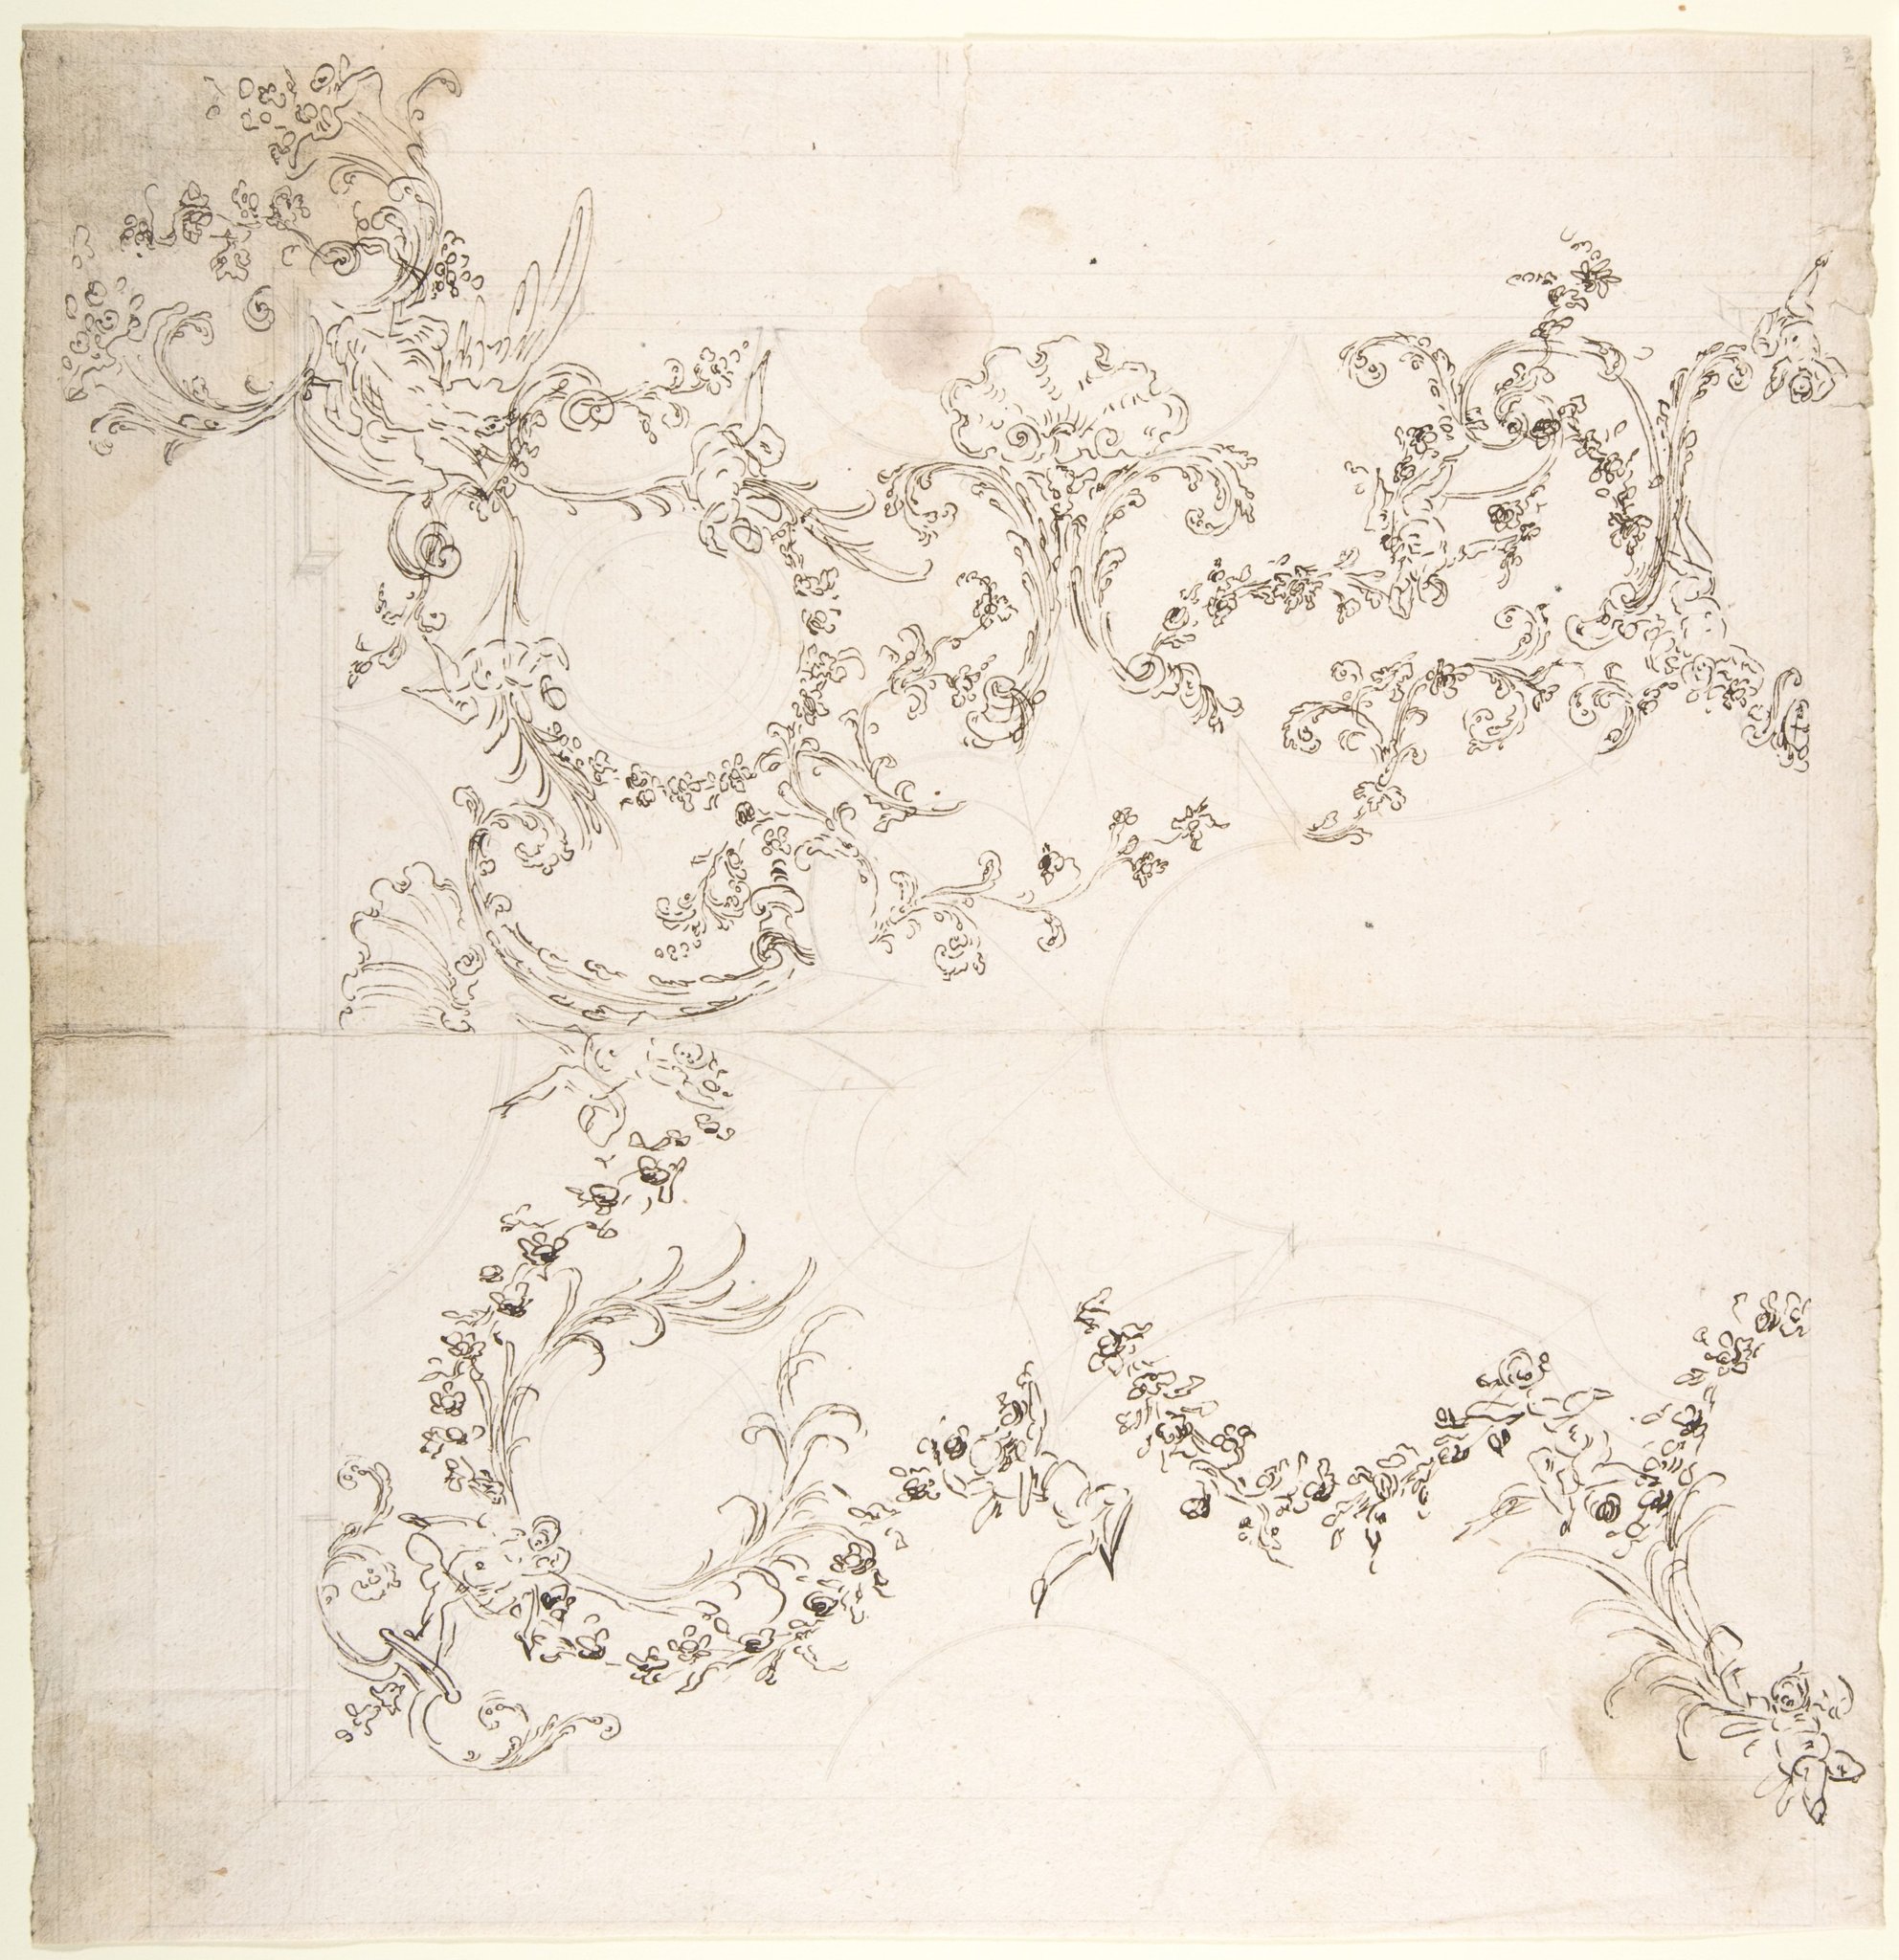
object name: drawing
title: Design for a Ceiling Decoration with Putti and Garland Motifs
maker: donato giuseppe frisoni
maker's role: artist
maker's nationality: italian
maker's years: 1683-1735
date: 1709-1720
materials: graphite, ink, drawing material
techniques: pen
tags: garlands